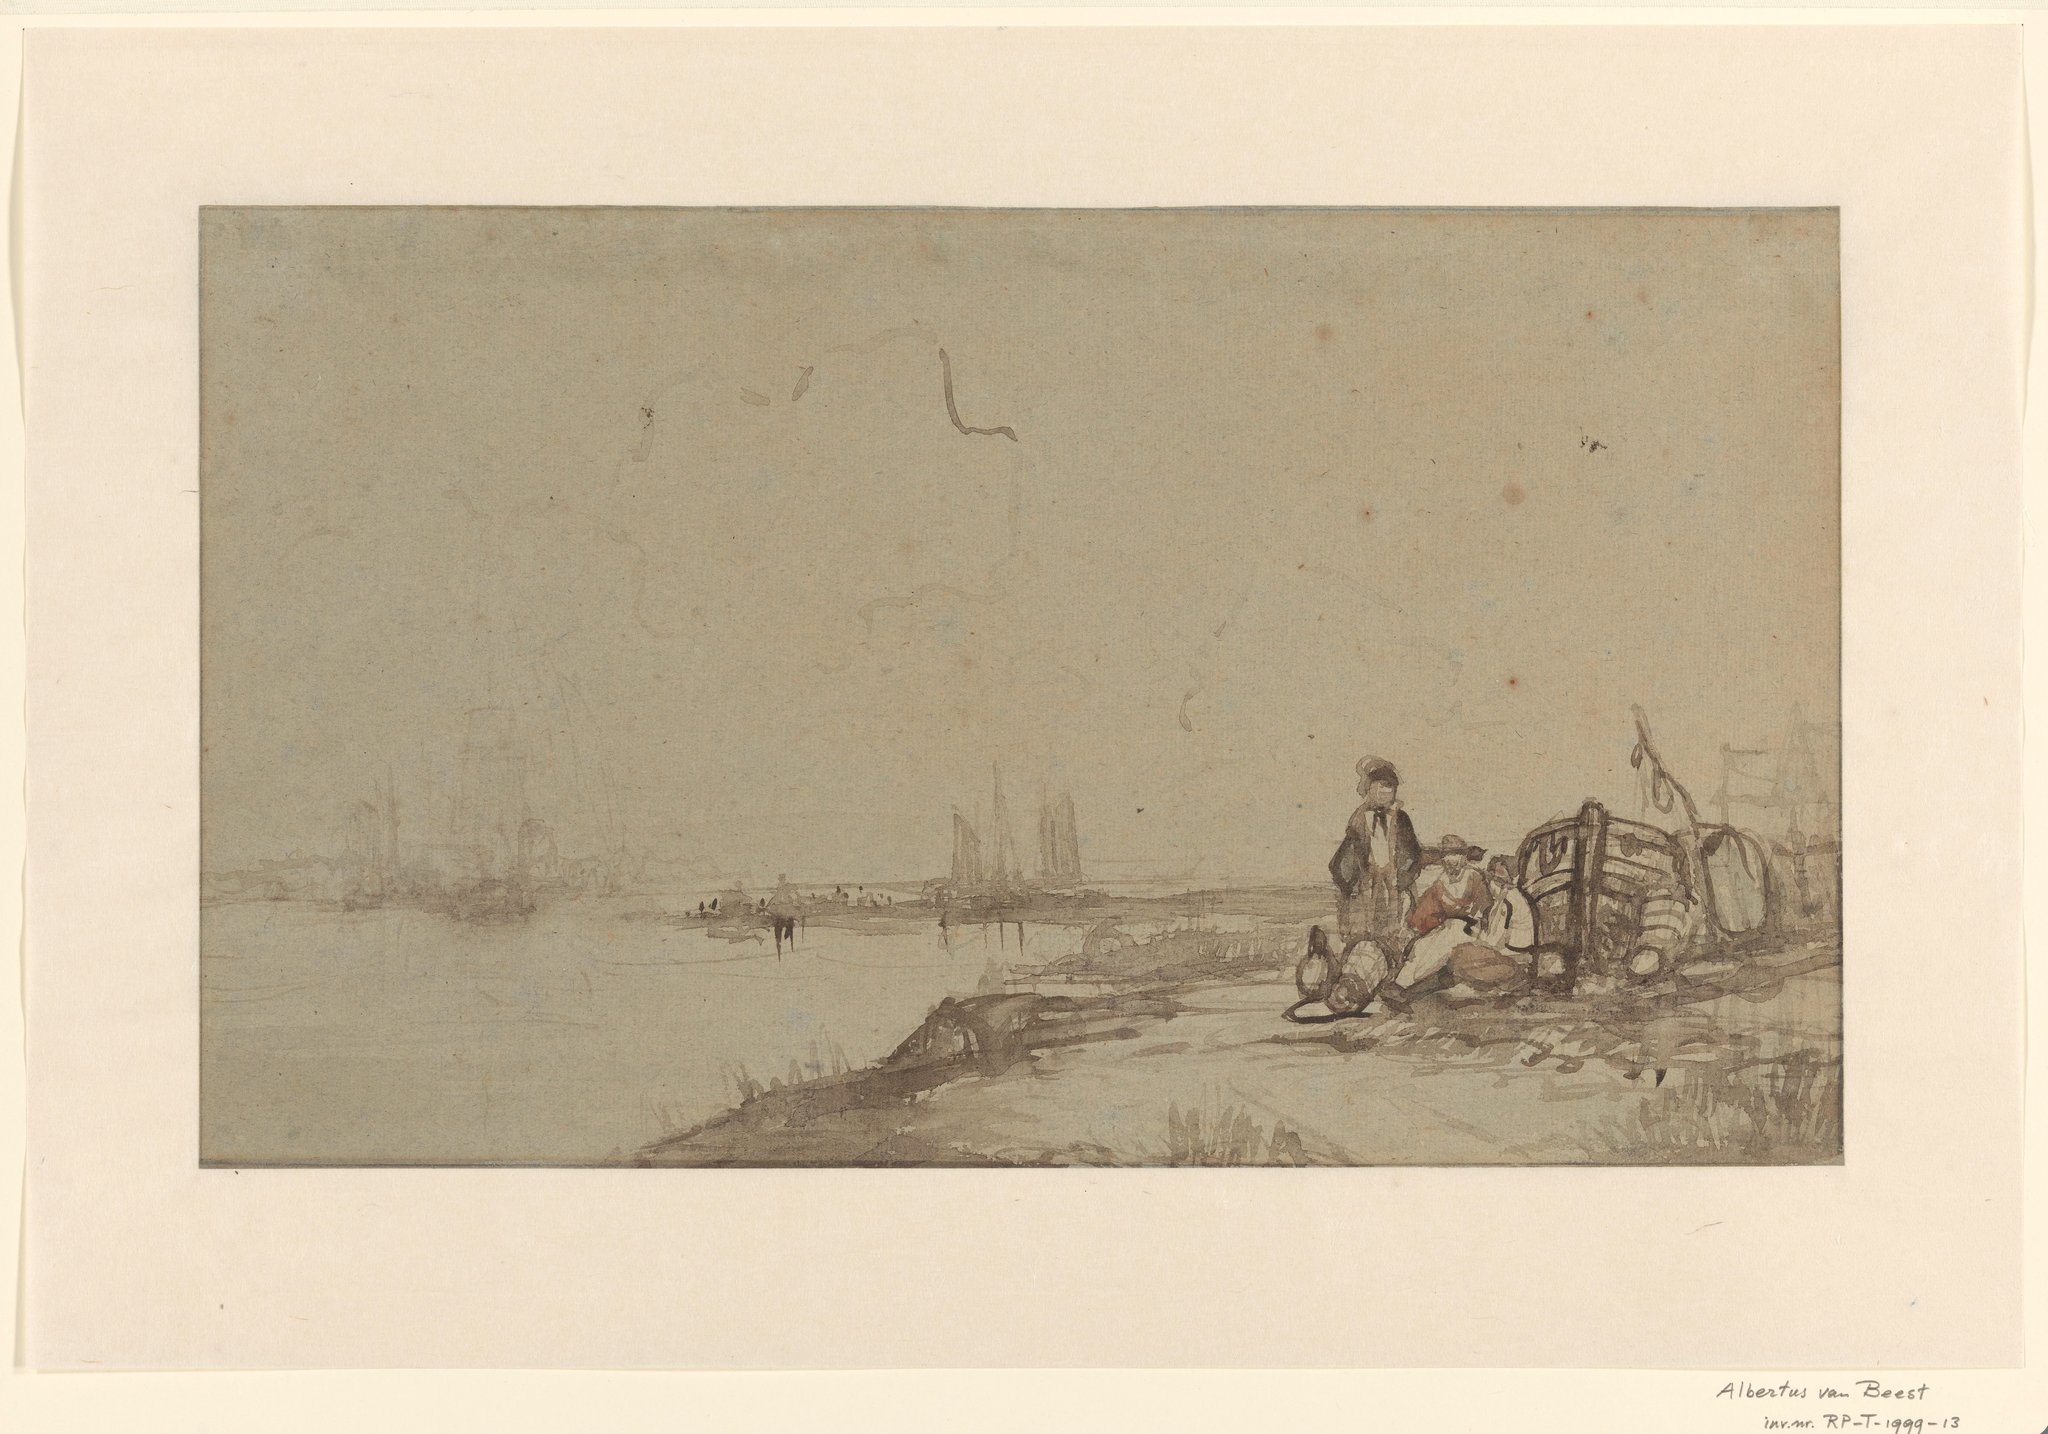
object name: drawing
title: Figuren in gesprek aan de oever van een bevaren rivier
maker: albertus van beest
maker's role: draughtsman, print maker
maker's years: 1820-1860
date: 1830-1860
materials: paper, pencil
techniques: brush